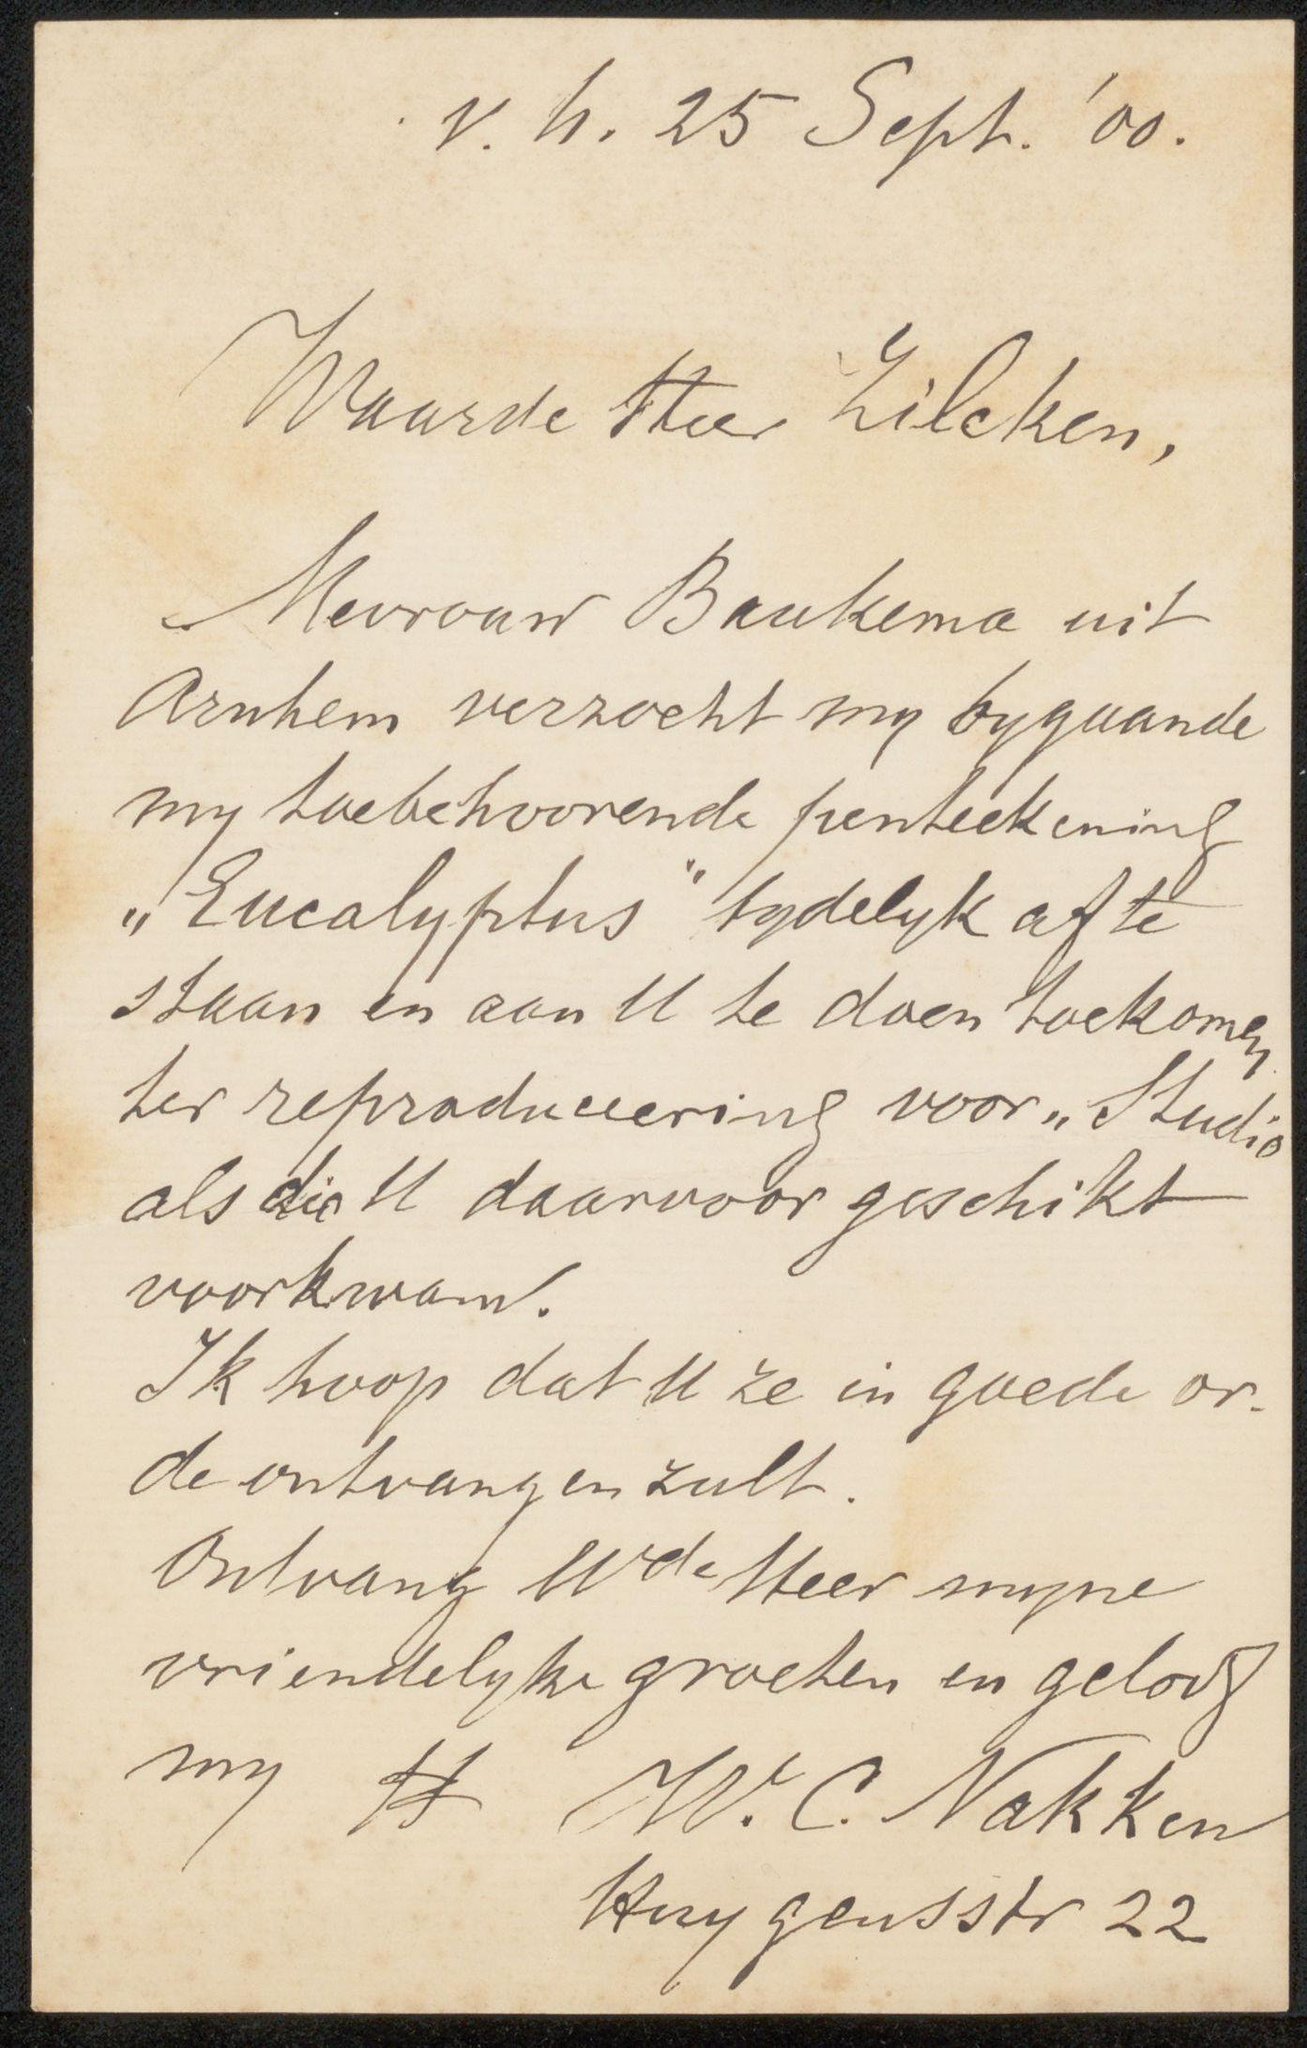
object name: letter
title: Brief aan Philip Zilcken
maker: willem carel nakken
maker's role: draughtsman, painter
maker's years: 1835-1926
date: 1900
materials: ink, paper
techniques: pen, writing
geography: the hague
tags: philip zilcken, drawing, printed matter, arnhem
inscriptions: watermark, collector's mark: ‘RPK’